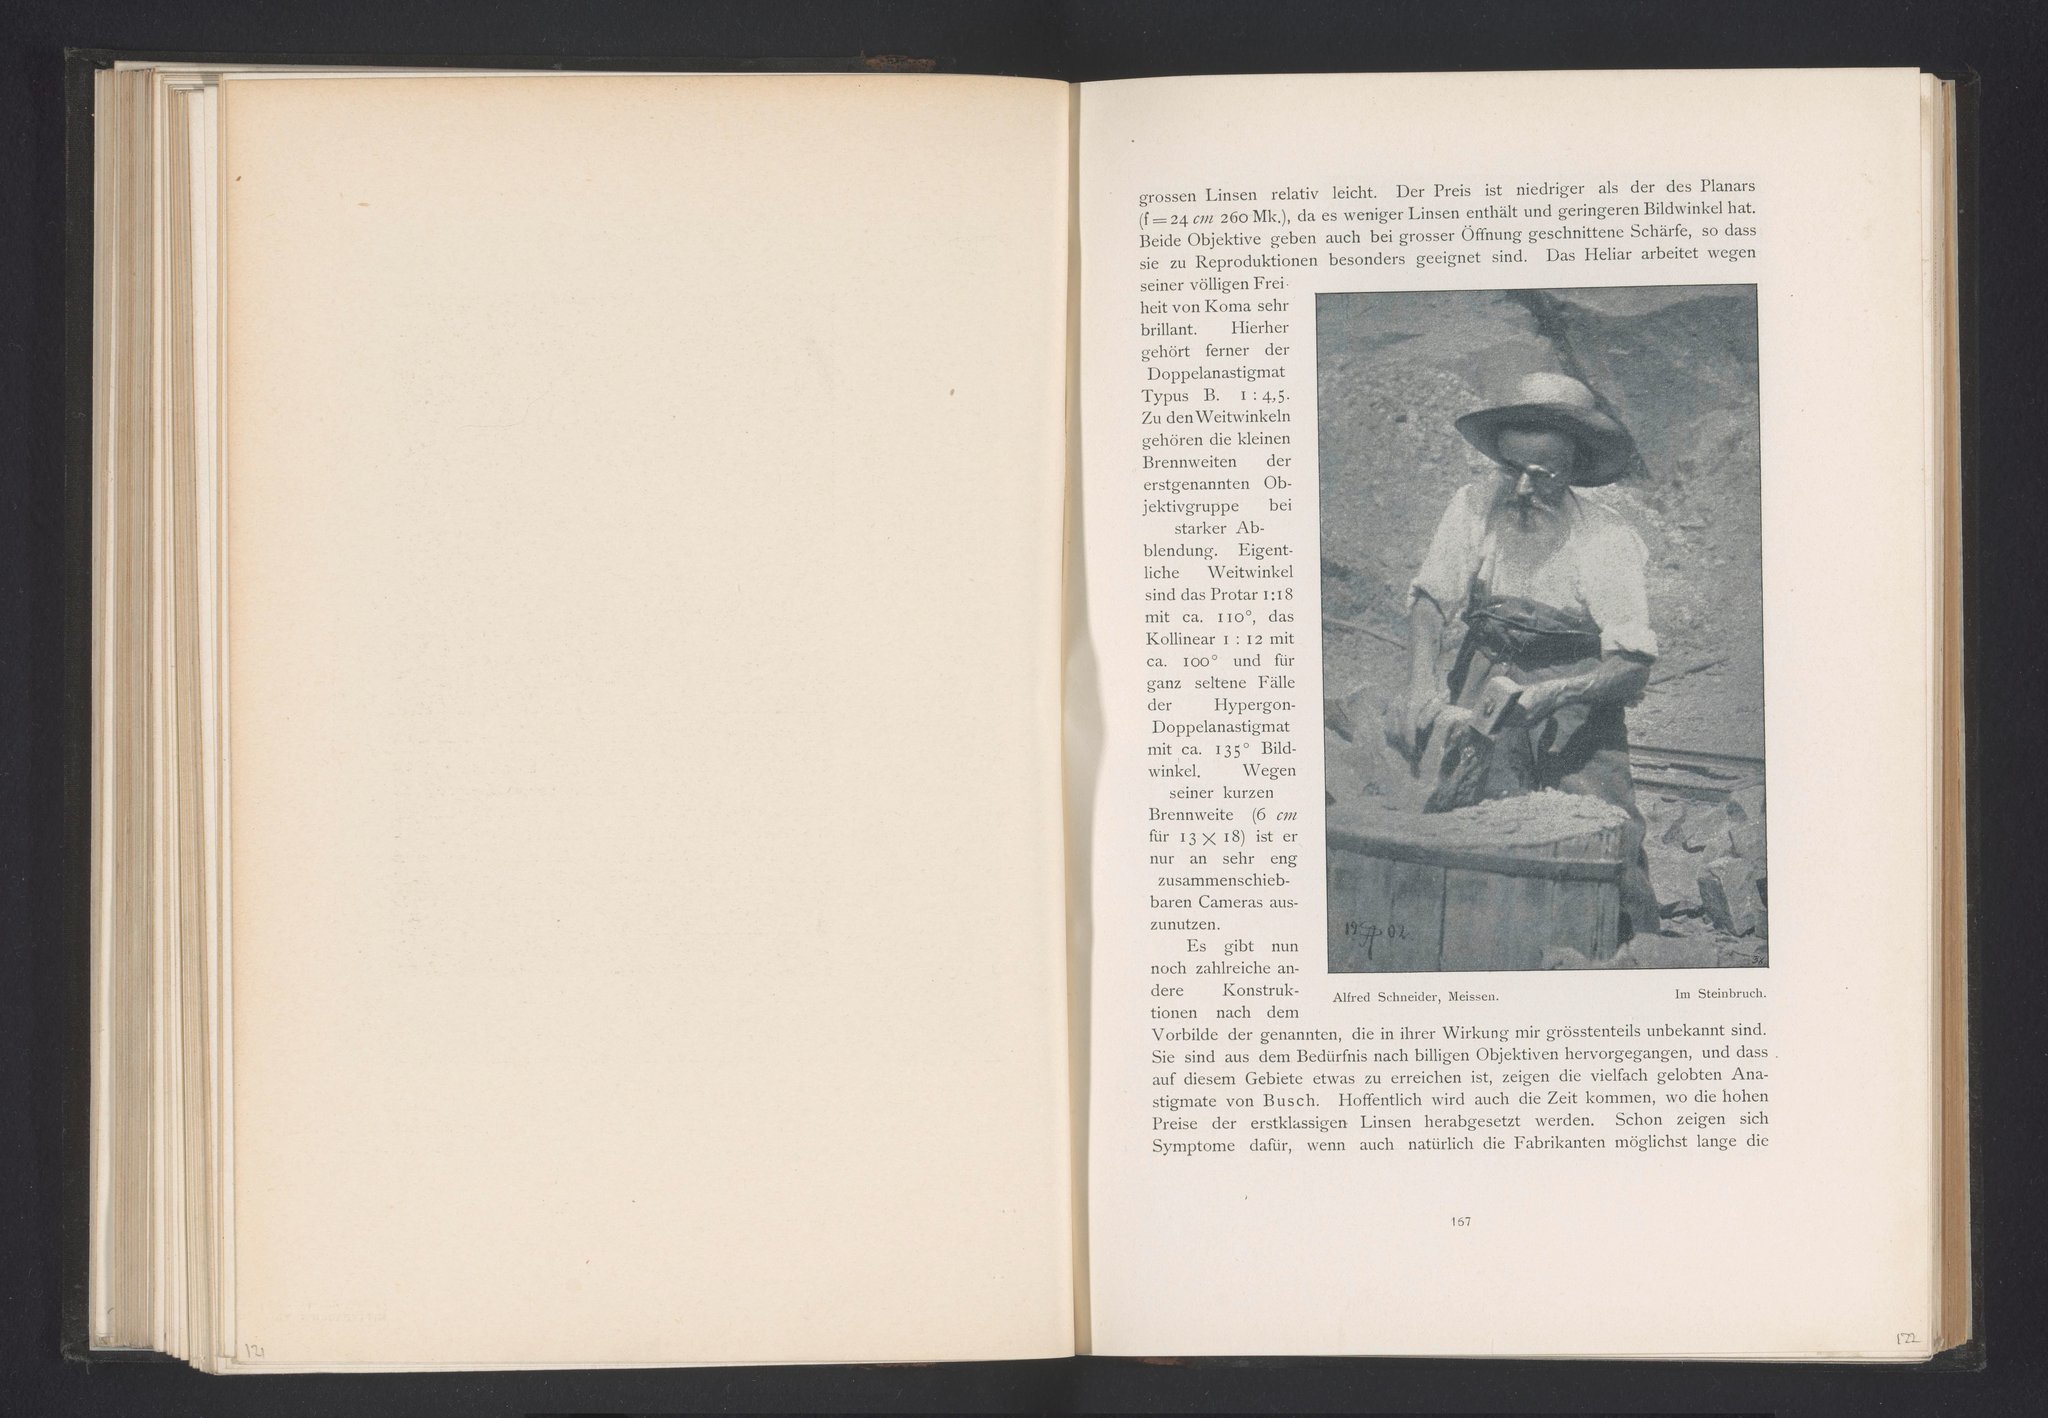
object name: page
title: Werkende man in een steengroeve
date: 1898-1903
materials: paper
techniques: autotype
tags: historical persons, quarry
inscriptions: monogram: ‘BX’, monogram: ‘AS 1902’